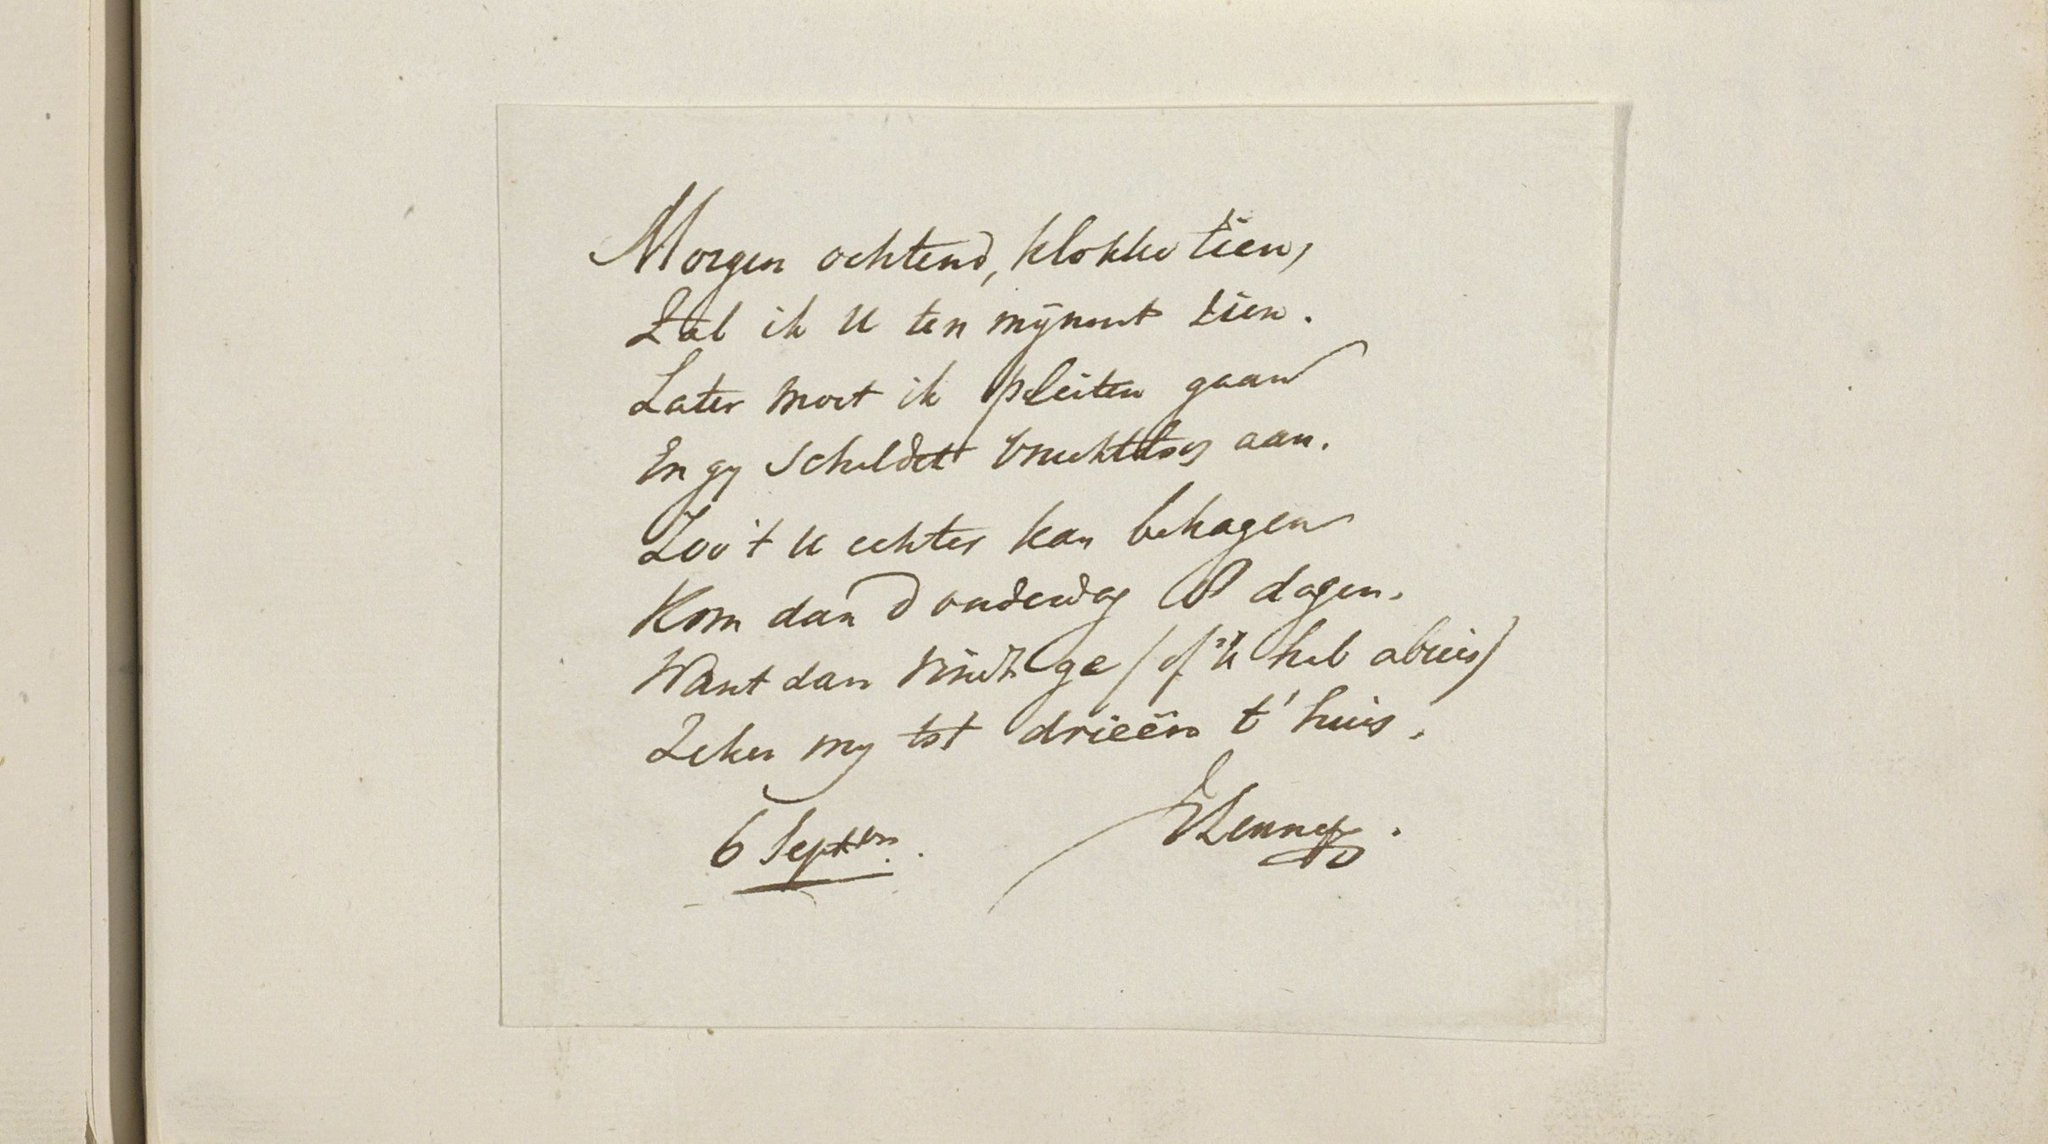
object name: letter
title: Brief met versje aan Martinus Gerardus Tetar van Elven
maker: jacob van lennep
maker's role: tweede kamerlid, advocaat, dichter, historicus, lid tweede kamer, schrijver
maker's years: 1802-1868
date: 1806-1848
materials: ink, paper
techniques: pen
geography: amsterdam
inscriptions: date and inscription: ‘Geschreven in de Akademie/ naar en gericht aan/ M.G. Tetar van Elven/ 6 sept - 1848-’, date and inscription: ‘Morgen ochtend, klokken tien,/ Zal ik u ten mijnent zien./ Later moet ik pleiten gaan/ En gij schildert vruchtloos aan./ Zoo 't u echter kan behagen/ Kom dan donderdag 8 dagen,/ Want dan vindt ge (of 'k heb abuis)/ zeker mij tot drieën thuis./ 6 septer/ vLennep’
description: Brief B op blad 6 recto uit een verzamelalbum met 32 bladen.